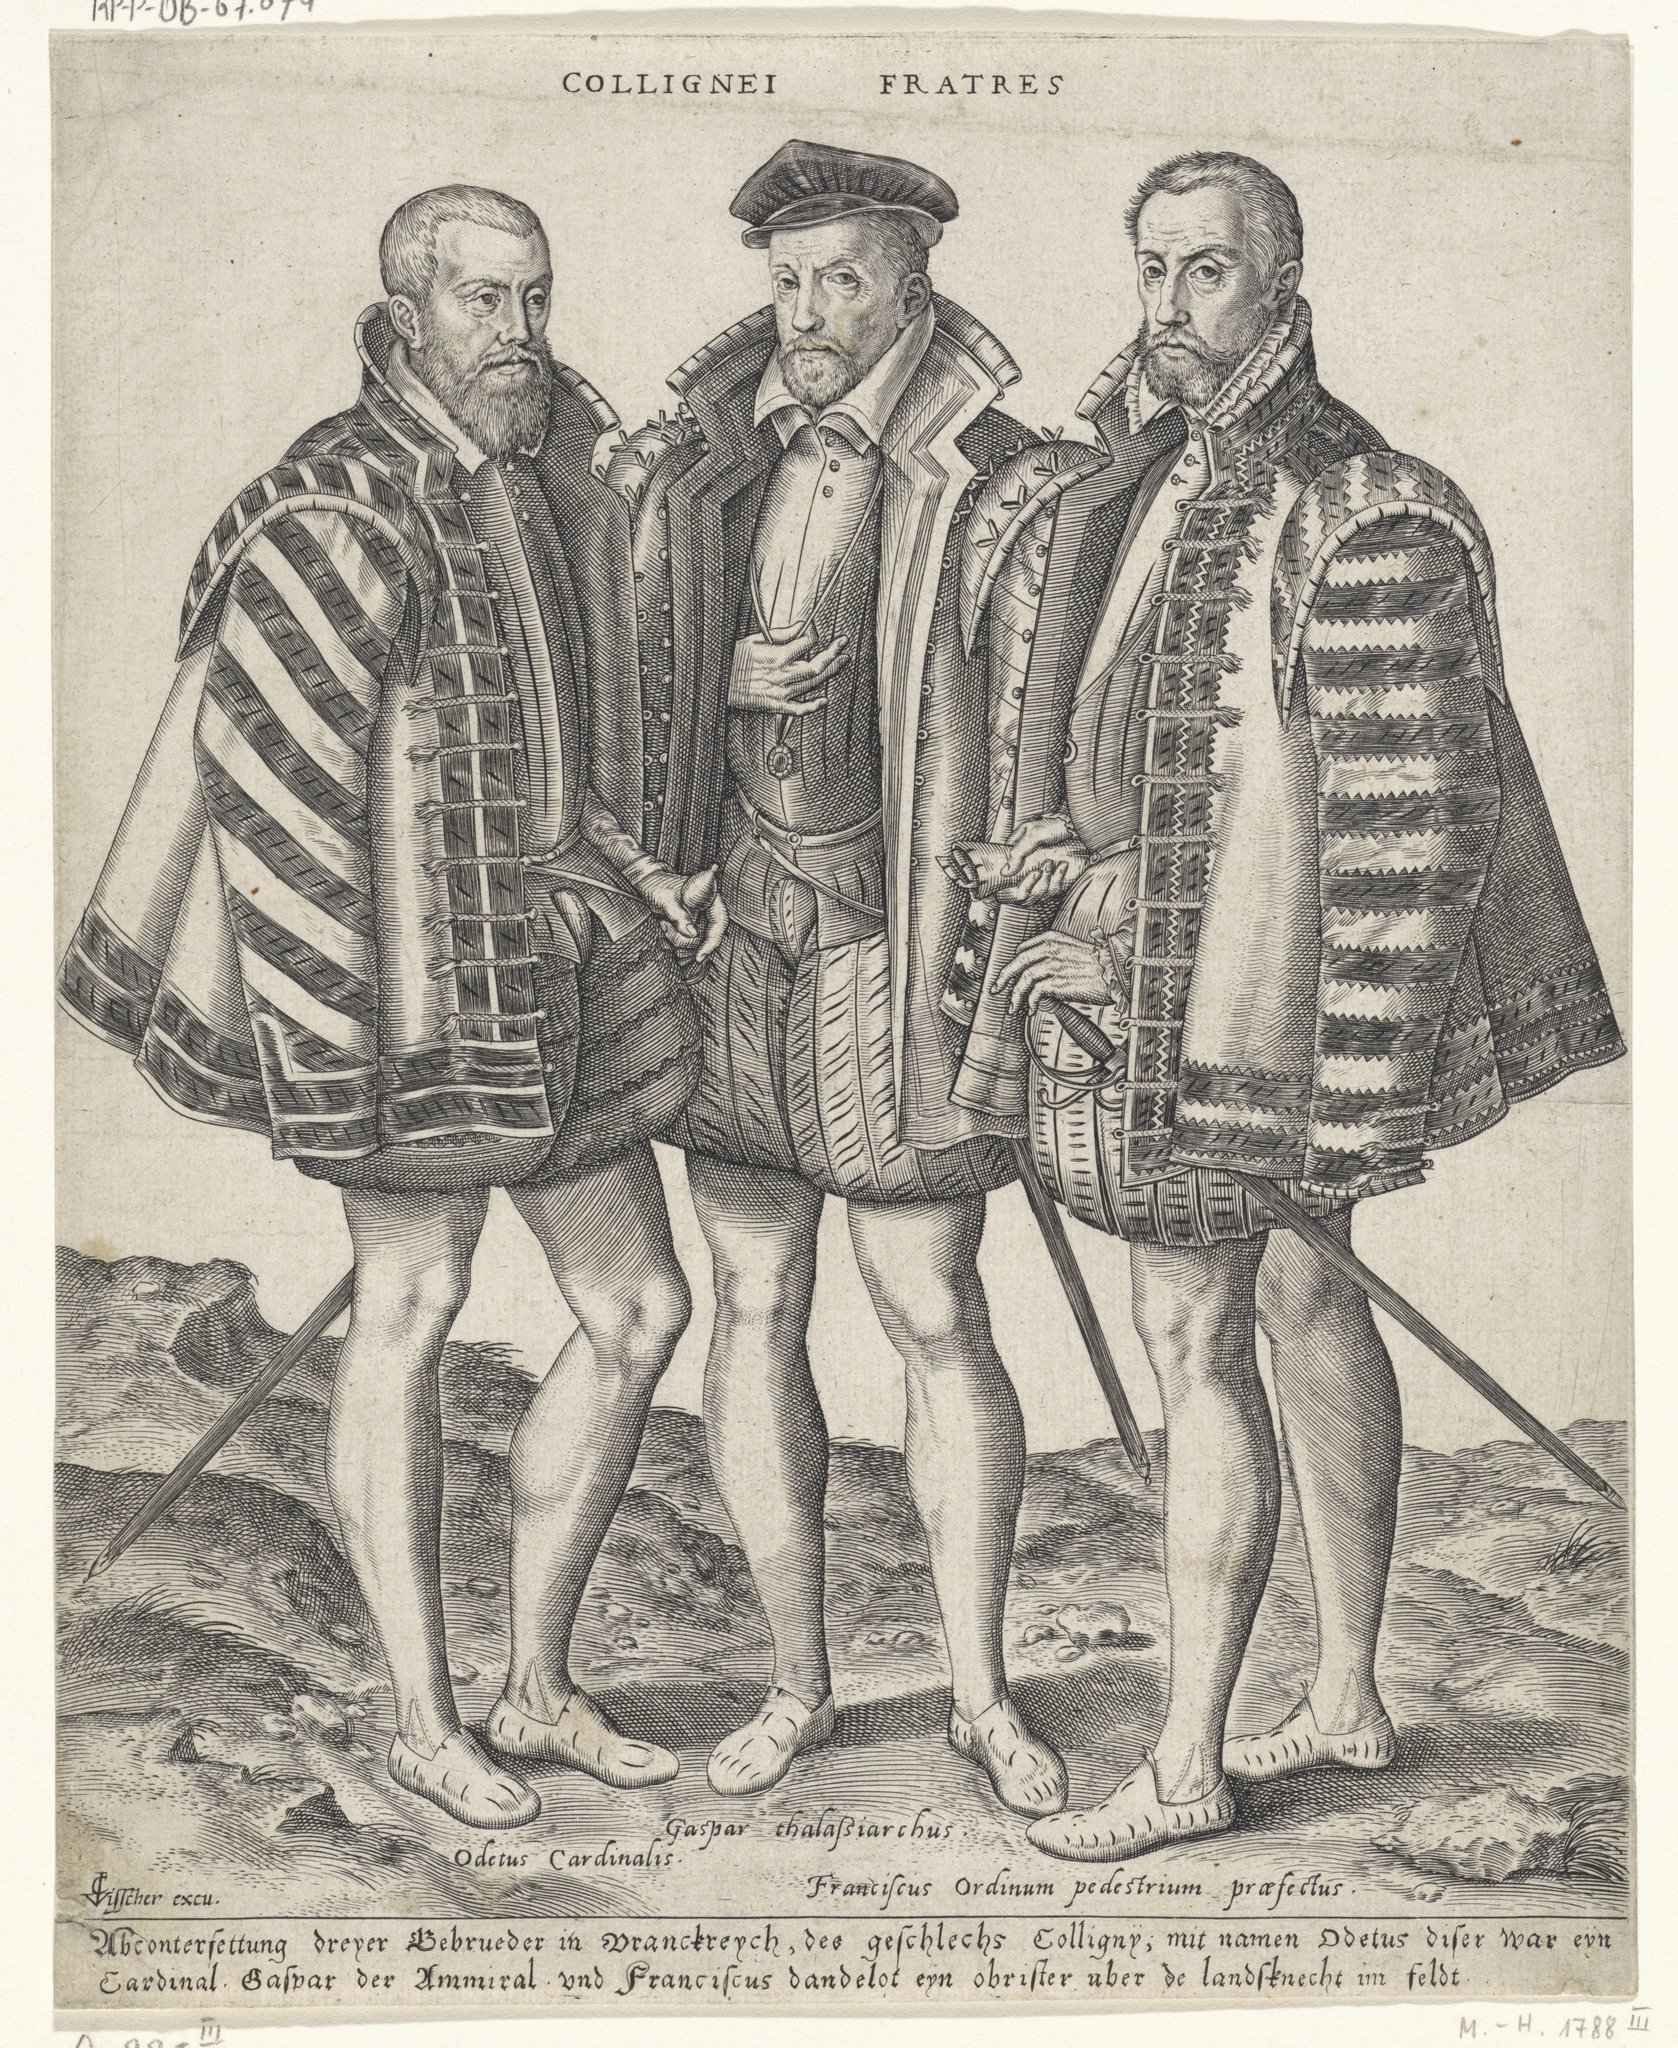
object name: print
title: Portret van de gebroeders Coligny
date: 1579-1612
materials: paper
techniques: engraving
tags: politician, gaspard de coligny (ii), coat (+ fur used for clothes), coat (+ men's clothes), shoes, sandals (+ men's clothes), clothes, costume (+ men's clothes), trousers, breeches, etc. (breeches) (+ men's clothes), clothing for the upper part of the body (doublet) (+ men's clothes), gloves, mittens, etc. (+ men's clothes), stockings, socks (+ men's clothes)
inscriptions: collector's mark: Lugt 2228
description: De gebroeders Coligny, van links naar rechts: Odet, kardinaal van Châtillon, Gaspard, admiraal van Frankrijk en François, generaal der infanterie. Ze zijn in de volledige Spaanse dracht gekleed. In de marge een tweeregelig onderschrift in het Duits.